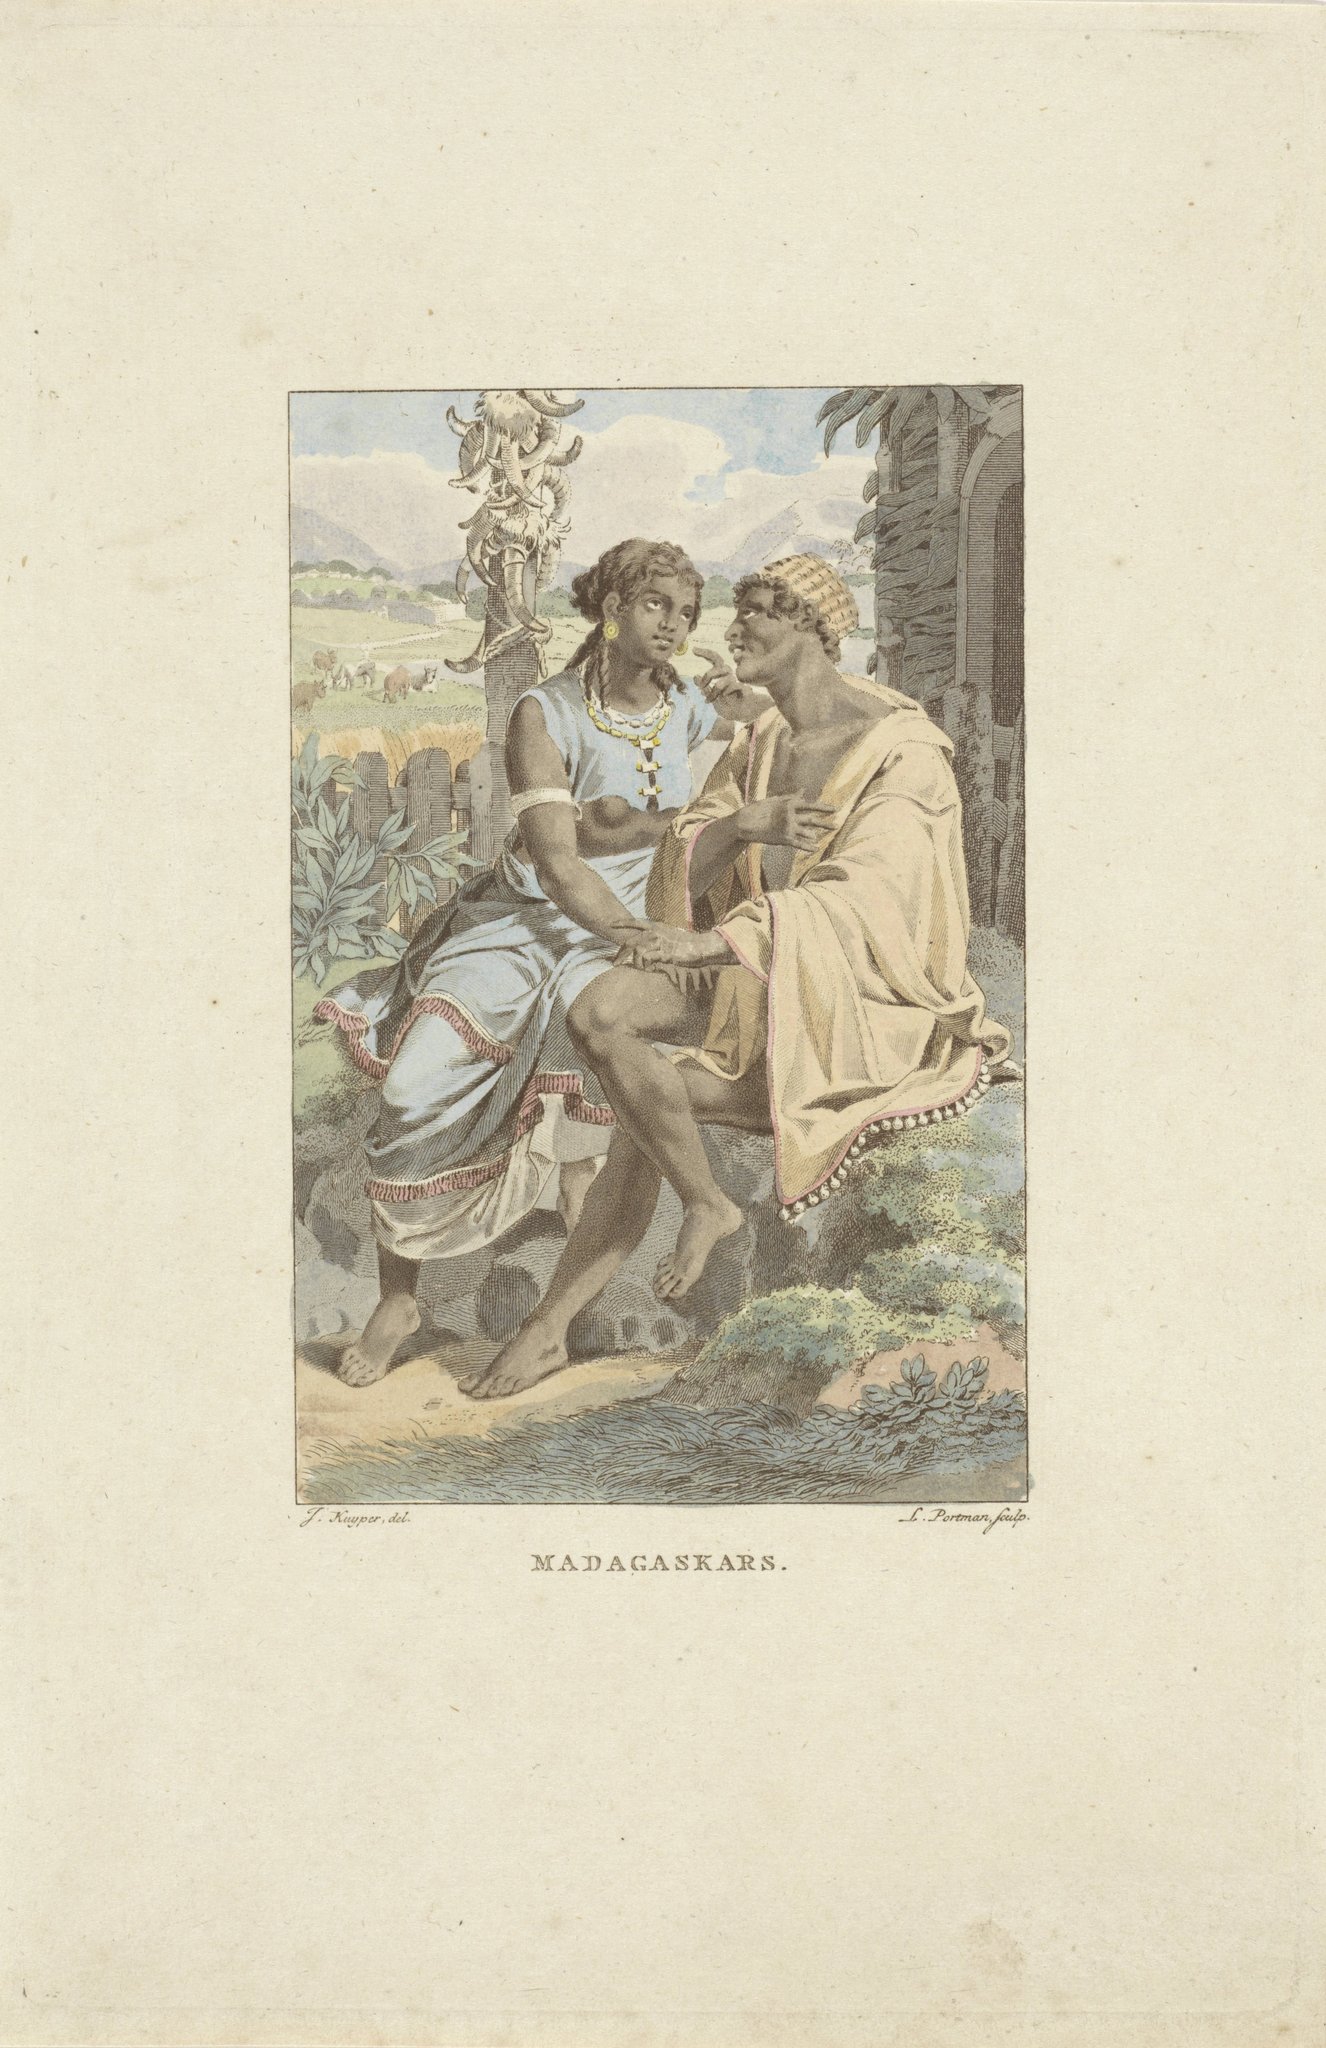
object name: book illustration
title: Madagaskars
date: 1806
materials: paper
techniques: etching, hand coloring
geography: amsterdam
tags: human races; peoples; nationalities (+ costume), (lovers) caressing each other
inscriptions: collector's mark: Lugt 2228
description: Illustratie uit: Stuart, Martinus. De mensch, zoo als hij voorkomt op den bekenden aardbol, deel V, p. 240. Amsterdam: Johannes Allart, 1806. De ontwerpstudie voor deze prent wordt bewaard in het prentenkabinet van de University Library Melbourne (1959.5668.000.000).